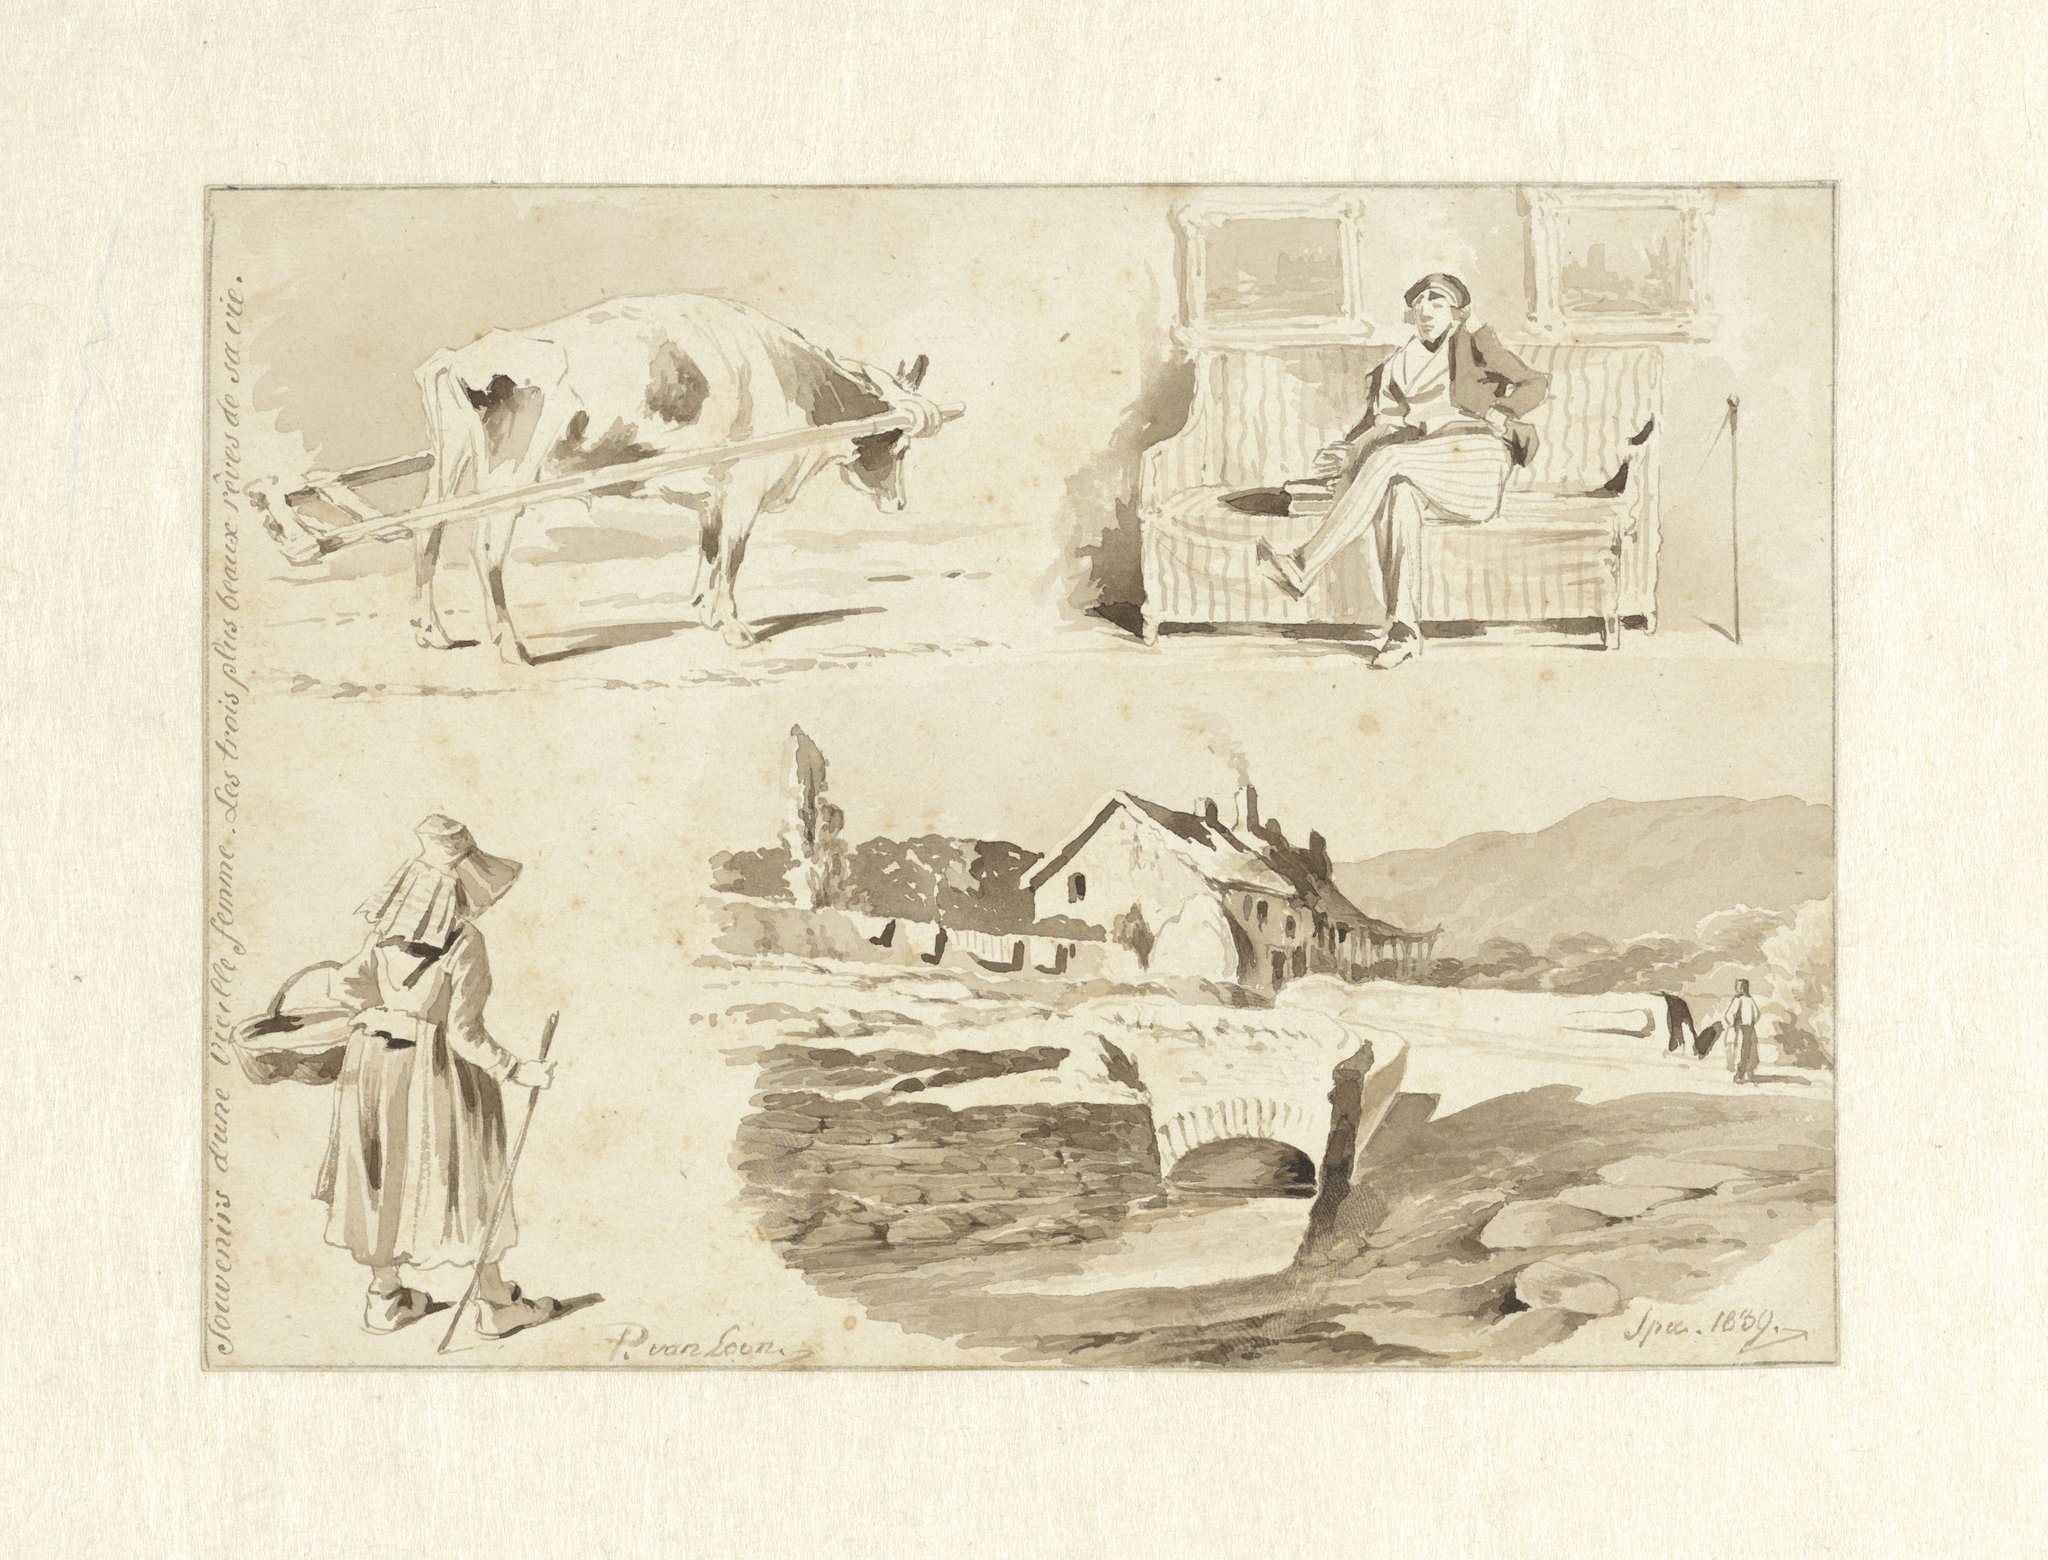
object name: drawing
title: Souvenirs d'une vieille femme. Les trois plus beaux rêves de sa vie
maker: pieter van loon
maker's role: draughtsman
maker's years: 1801-1873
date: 1839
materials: ink, paper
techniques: brush, pen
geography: spa